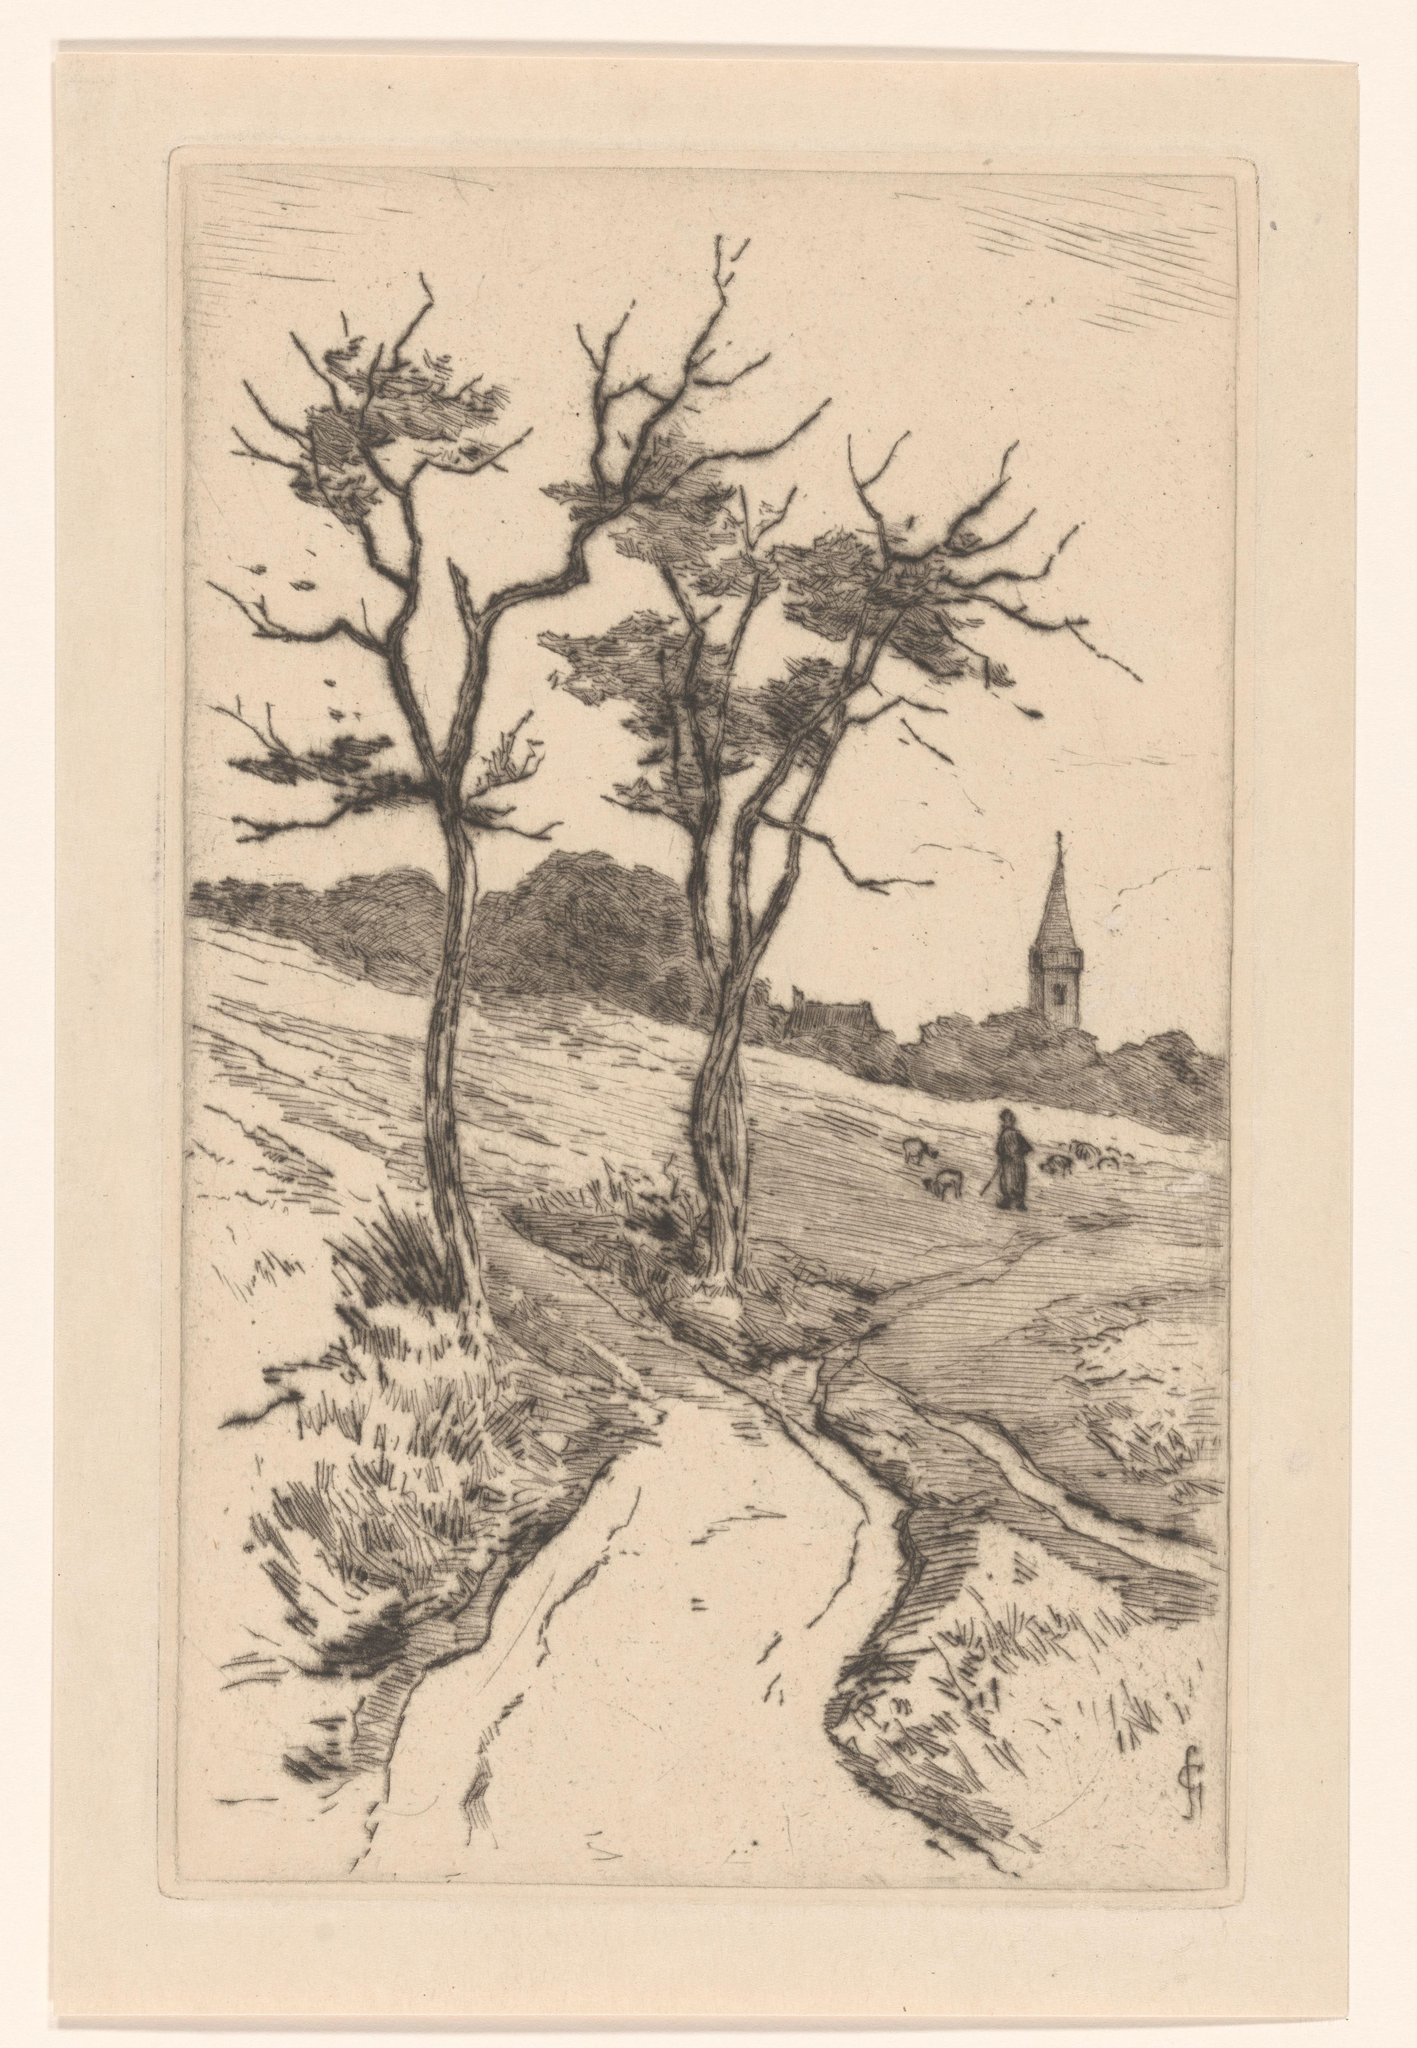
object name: print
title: Duinlandschap met kerktoren van Katwijk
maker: carel nicolaas storm van s-gravesande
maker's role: draughtsman, print maker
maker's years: 1841-1924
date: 1886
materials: paper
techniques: drypoint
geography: netherlands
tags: dunes (sea not visible); in the dunes (+ landscape with figures, staffage), parts of church exterior and annexes: tower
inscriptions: collector's mark: Lugt 2228